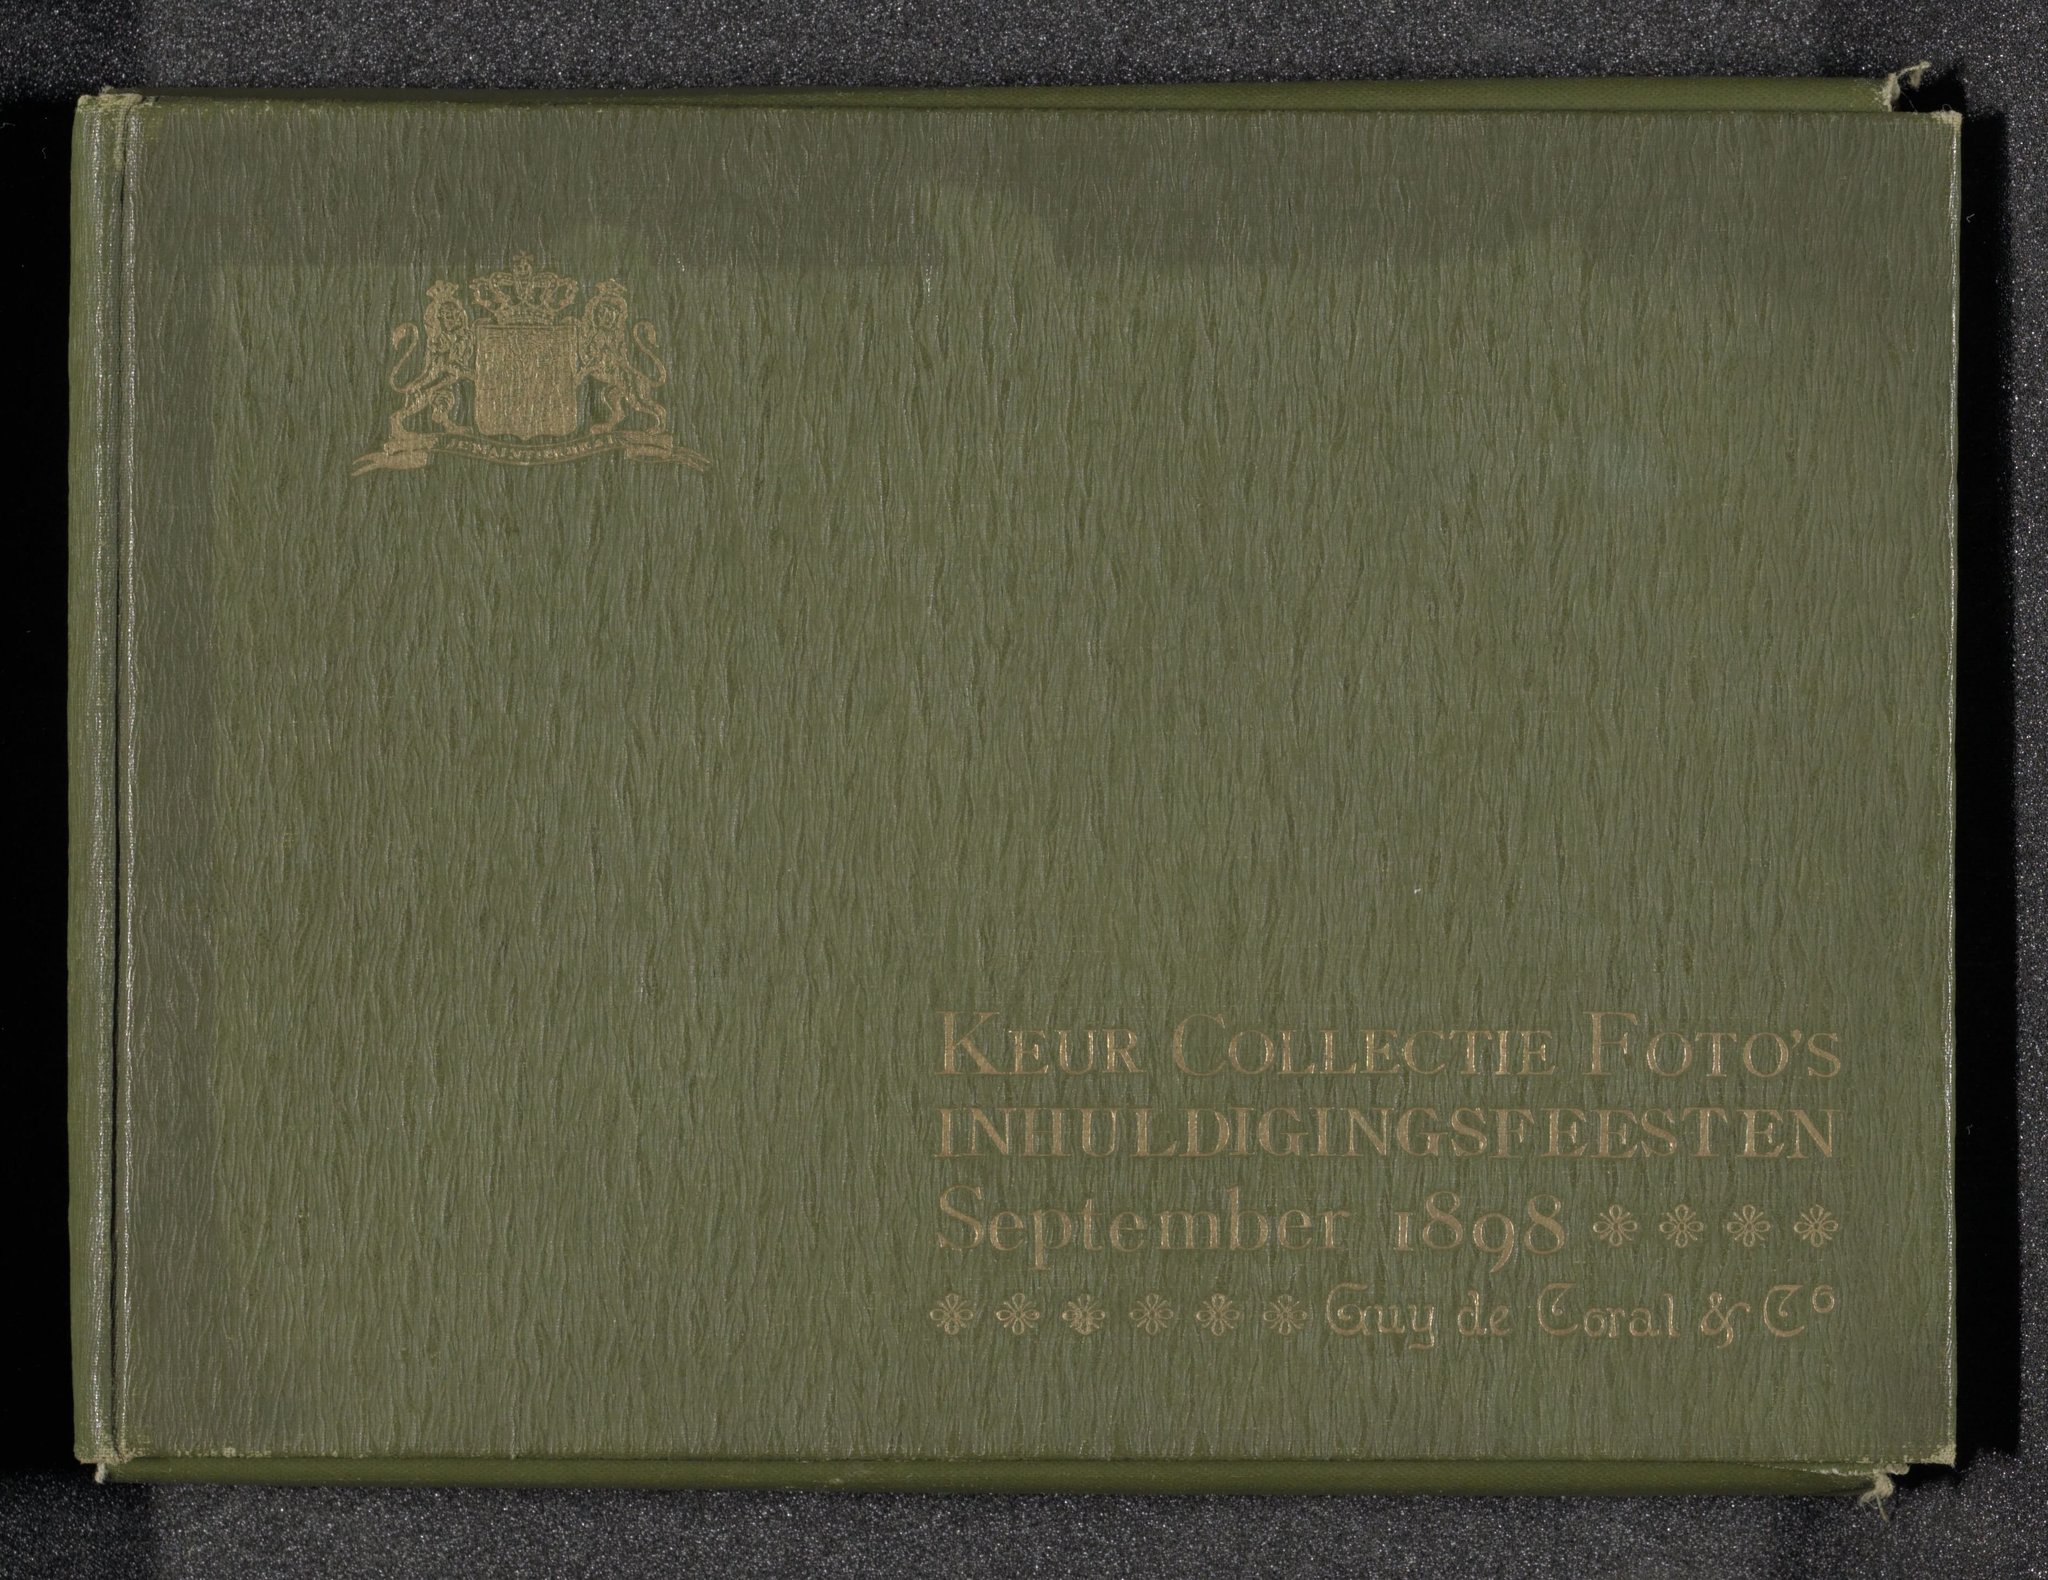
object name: verzamelalbum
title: Fotoalbum met 11 opnames van de inhuldiging van Koningin Wilhelmina en de inhuldigingsfeesten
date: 1809-1898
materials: cardboard, paper, photographic support, textile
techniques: collodion silver print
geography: netherlands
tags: the hague, print maker, wilhelmina of the netherlands, ceremonial celebration of installation of a ruler, public festivities on the occasion of royal events, installation of a ruler - bb - female ruler, netherlands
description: Groene verzamelmap met op de voorzijde in gouddruk de titel, de naam van de fotograaf en linksboven een wapenschild met daaronder de spreuk 'Je maintiendrai'. De map heeft aan de binnenkant 3 uitklapbare flappen. Het album bevat 11 foto's, op stevig karton geplakt. Het betreft opnames van de inhuldiging van Wilhelmina als koningin in september 1898 en van festiviteiten die in dit kader werden gehouden.